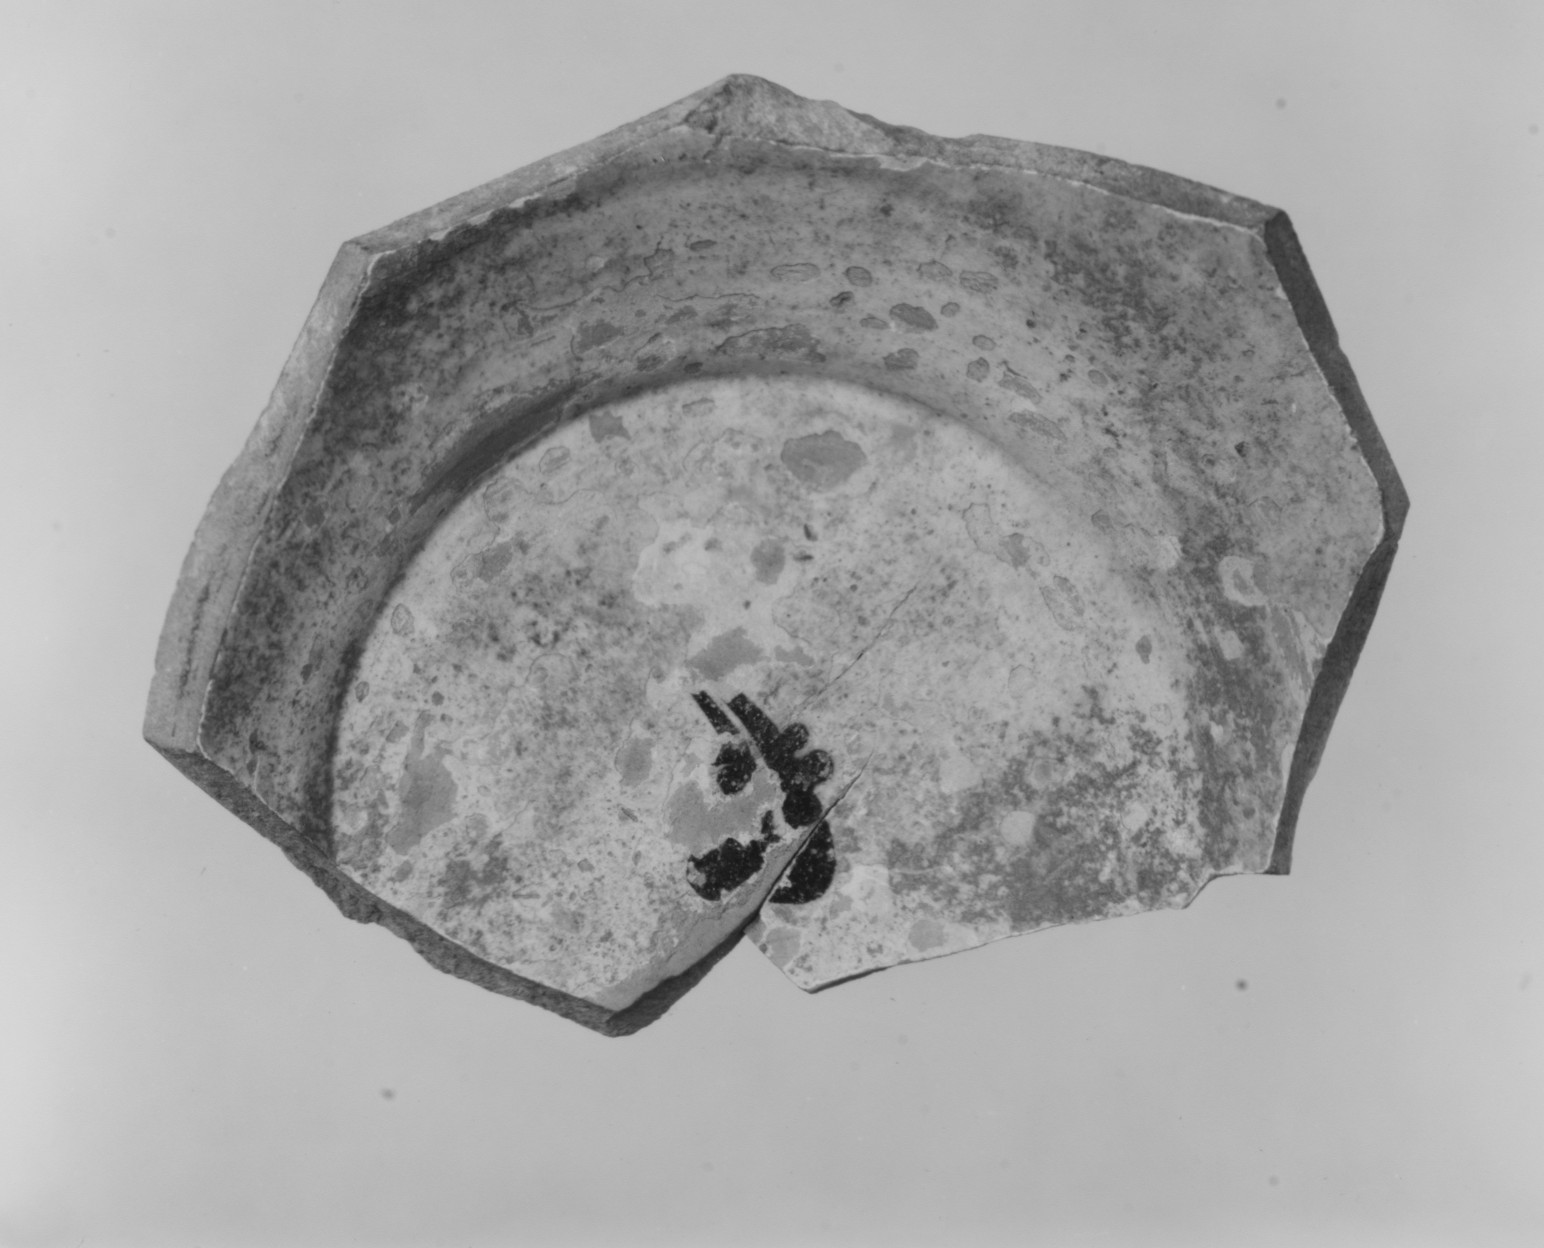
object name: fragment of a bowl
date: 901-1000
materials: earthenware, glaze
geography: iran